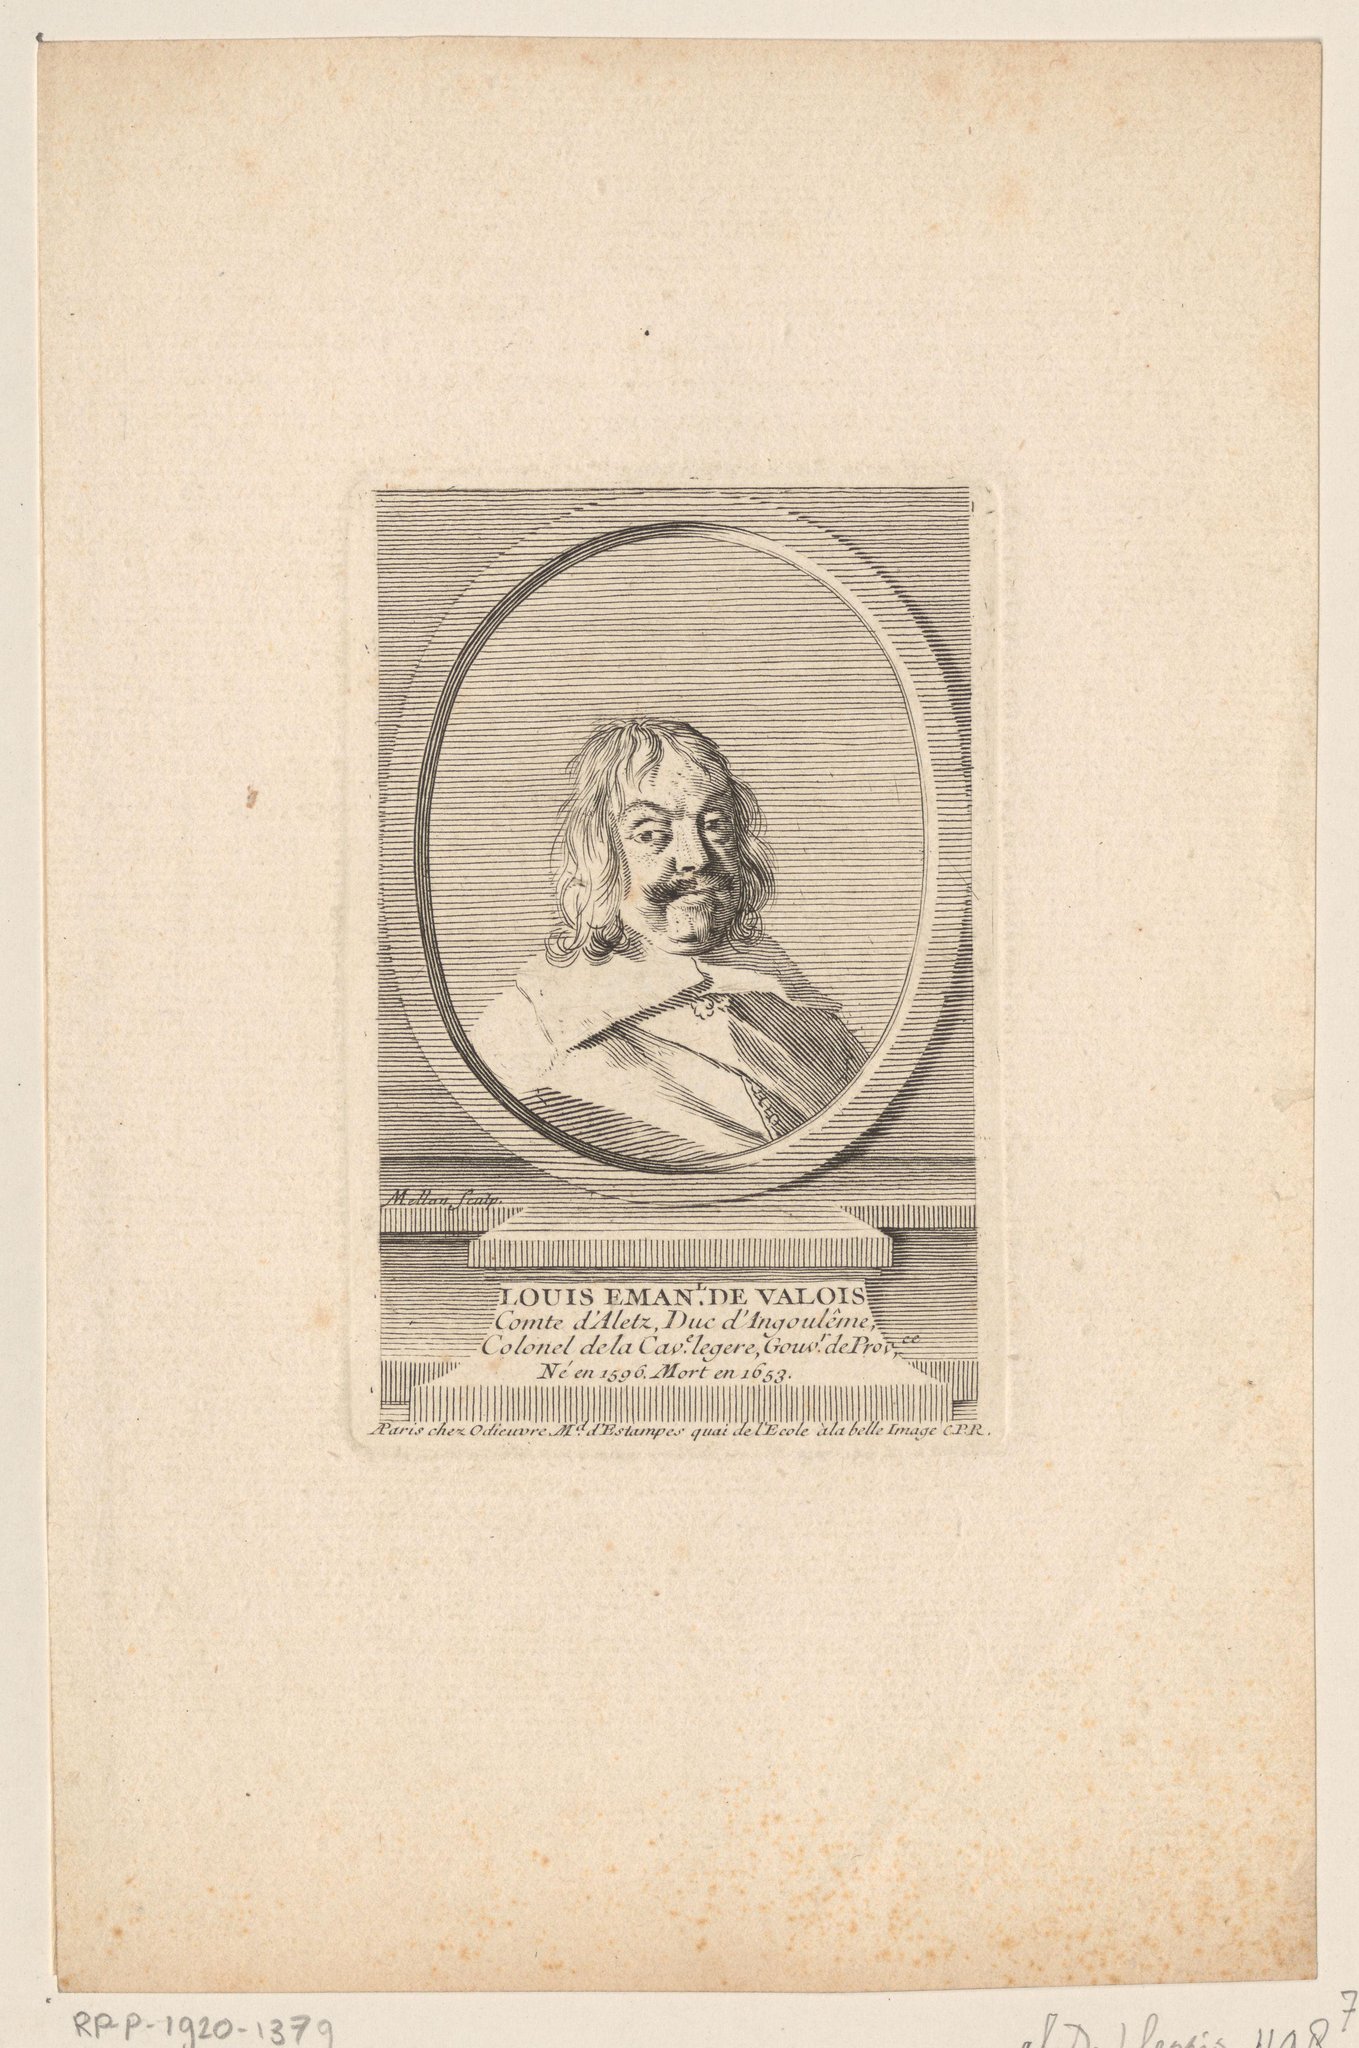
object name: print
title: Portret van Louis-Emmanuel de Valois, hertog van Angoulême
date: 1653-1688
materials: paper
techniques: etching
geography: paris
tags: historical persons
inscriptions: collector's mark: Lugt 2228